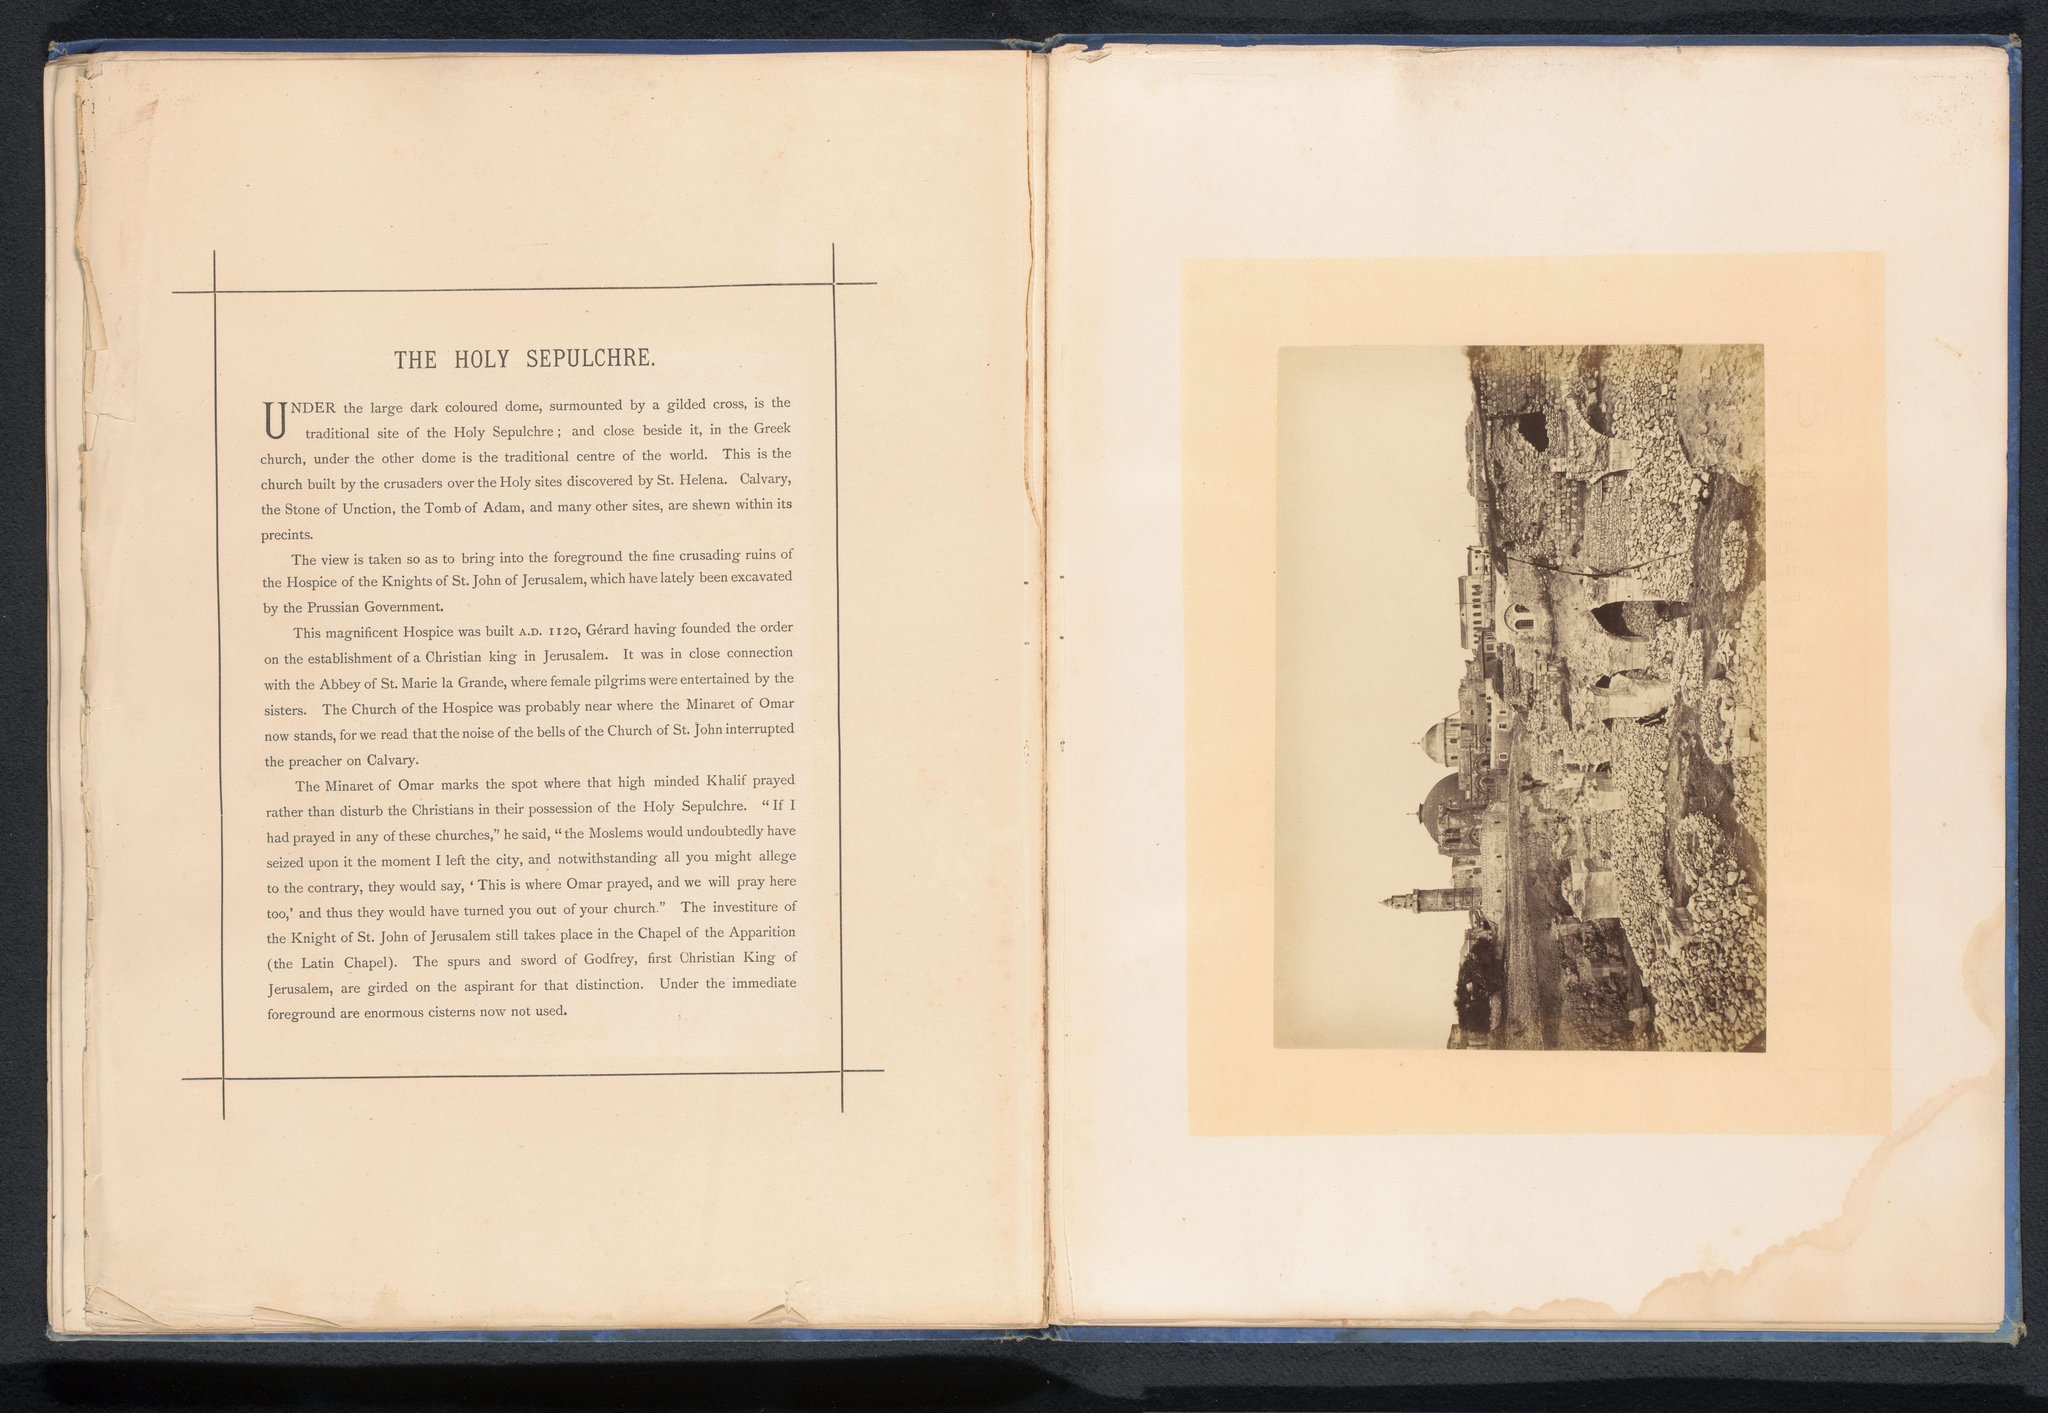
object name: page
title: Gezicht op de Heilig Grafkerk te Jeruzalem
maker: horatio herbert kitchener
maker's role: fotograaf, luitenant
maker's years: 1850-1916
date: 1870-1875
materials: photographic support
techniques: albumen print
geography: jerusalem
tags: city-view in general; 'veduta', church (exterior)